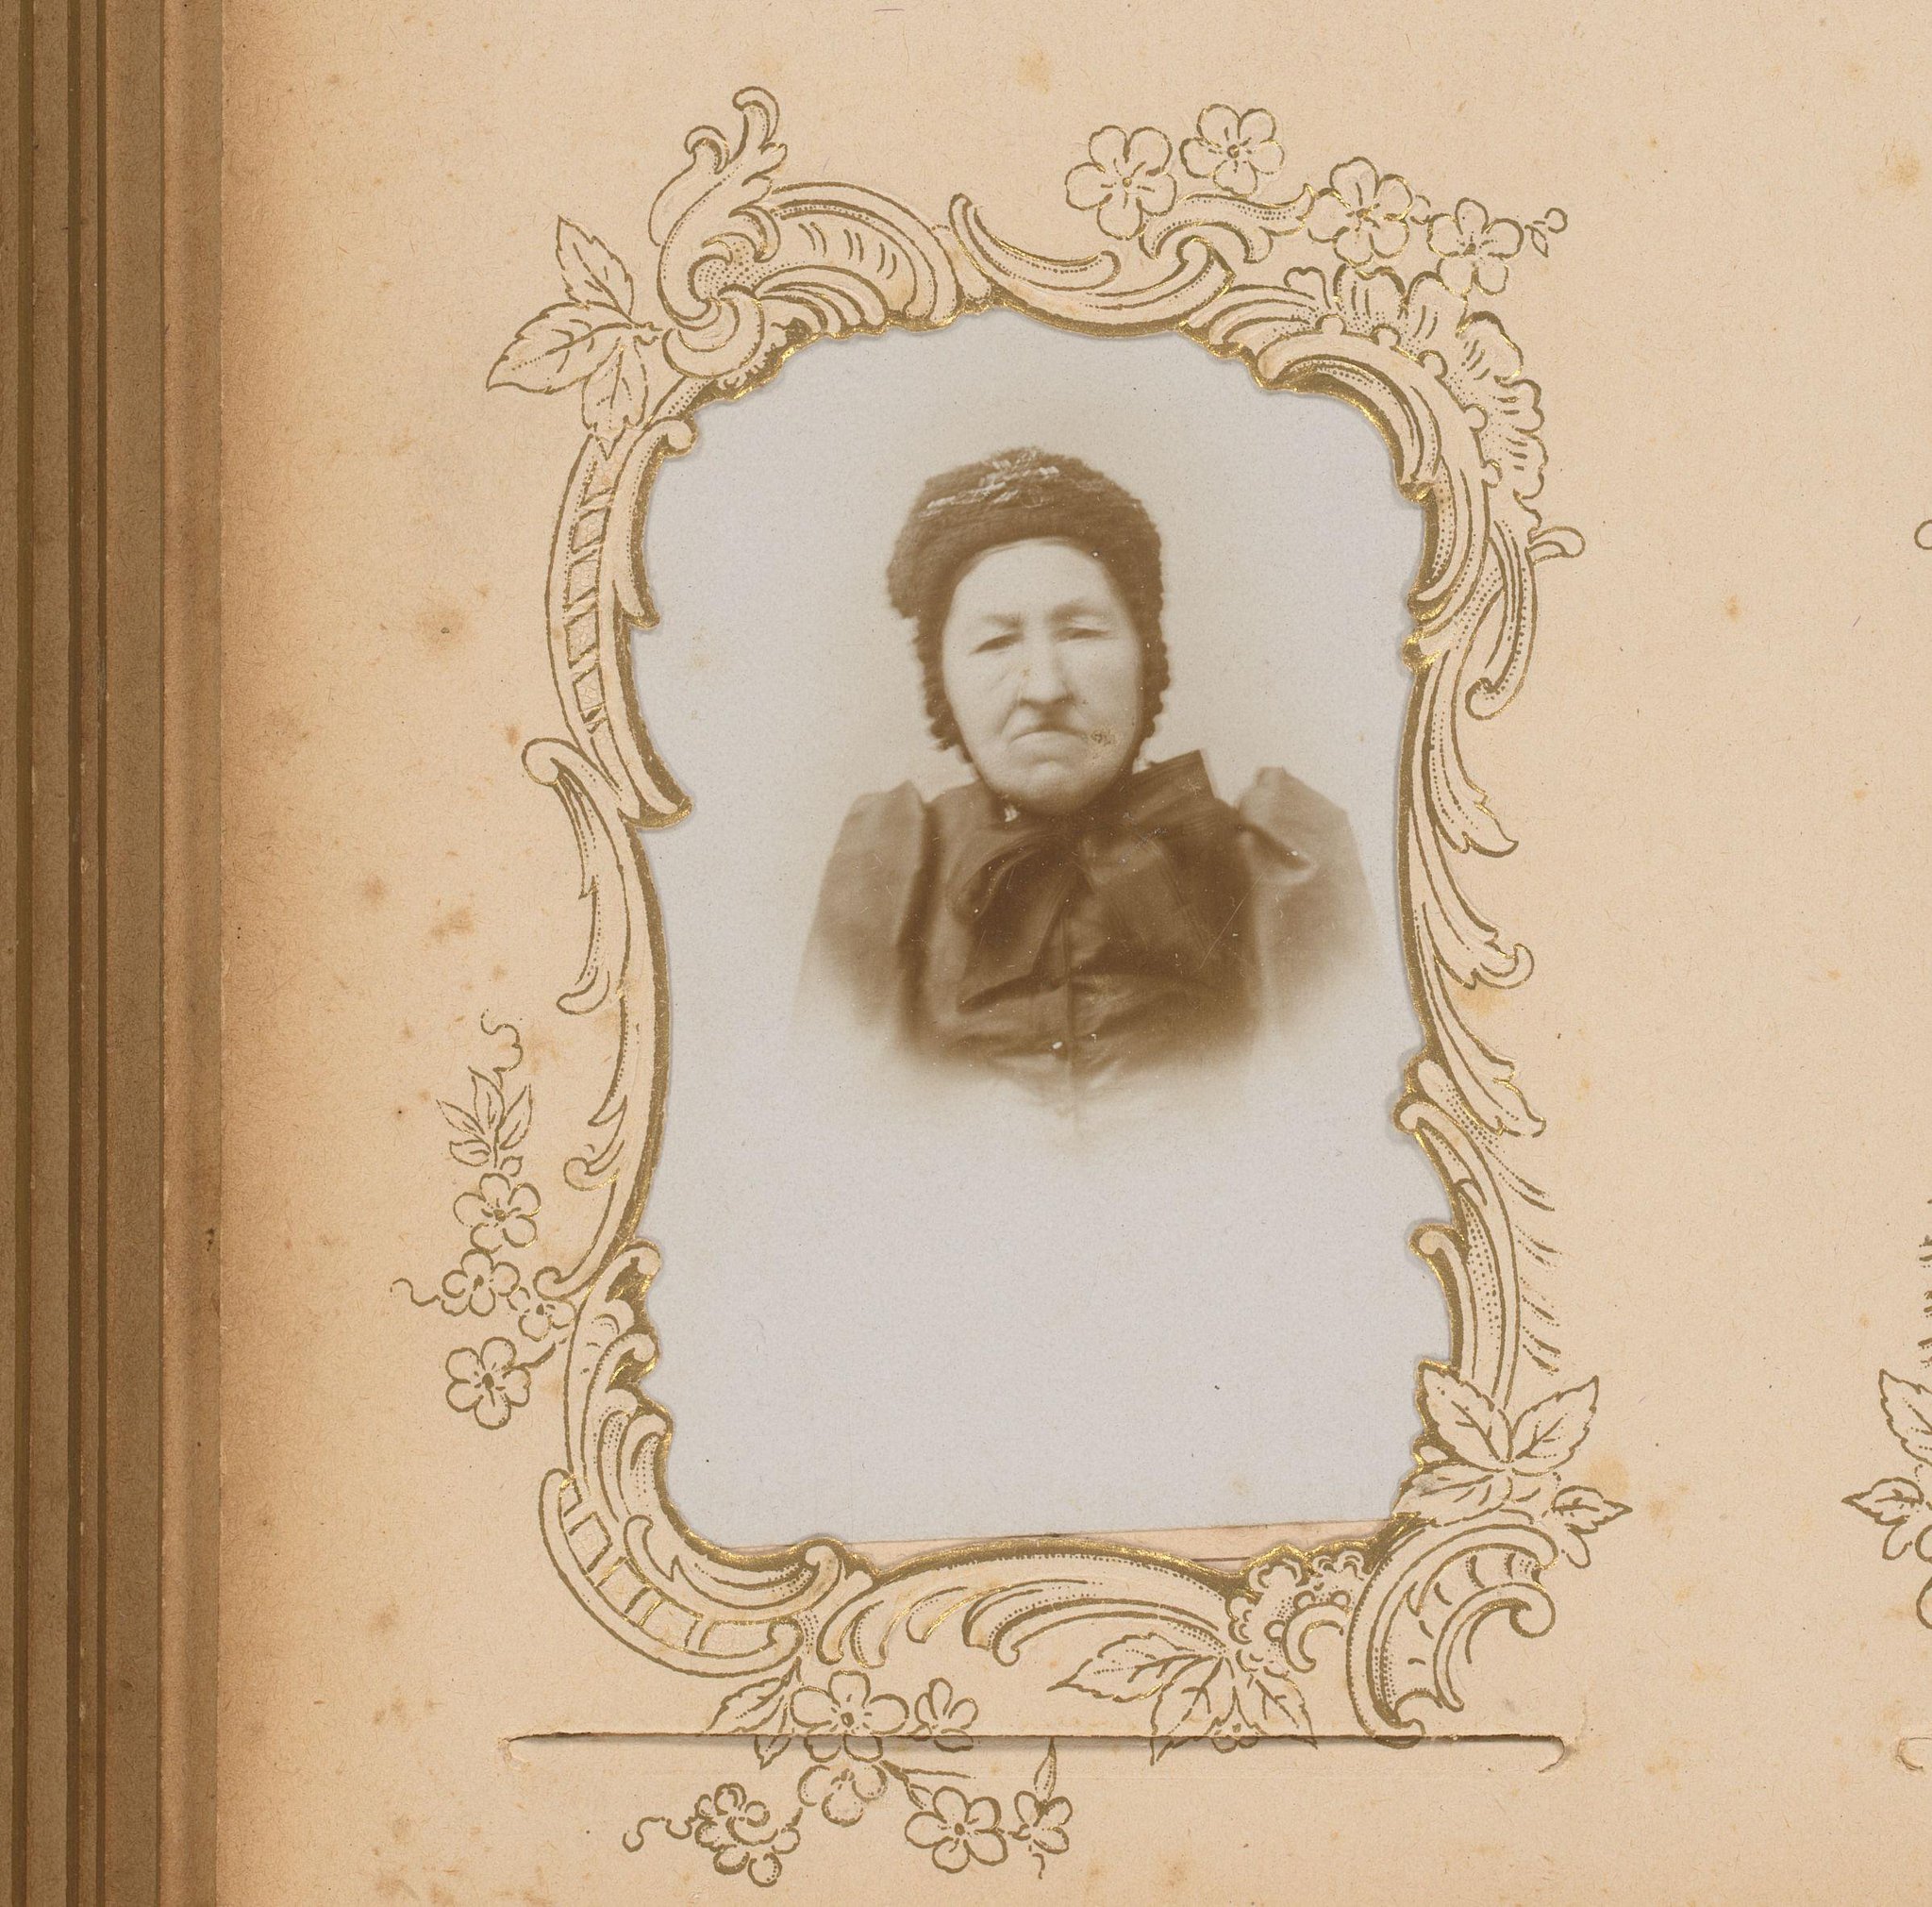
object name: carte de visite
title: Portret van een oude vrouw met muts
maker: Anonymous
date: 1880-1910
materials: cardboard, photographic support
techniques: albumen print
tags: adolescent, young woman, maiden, historical persons